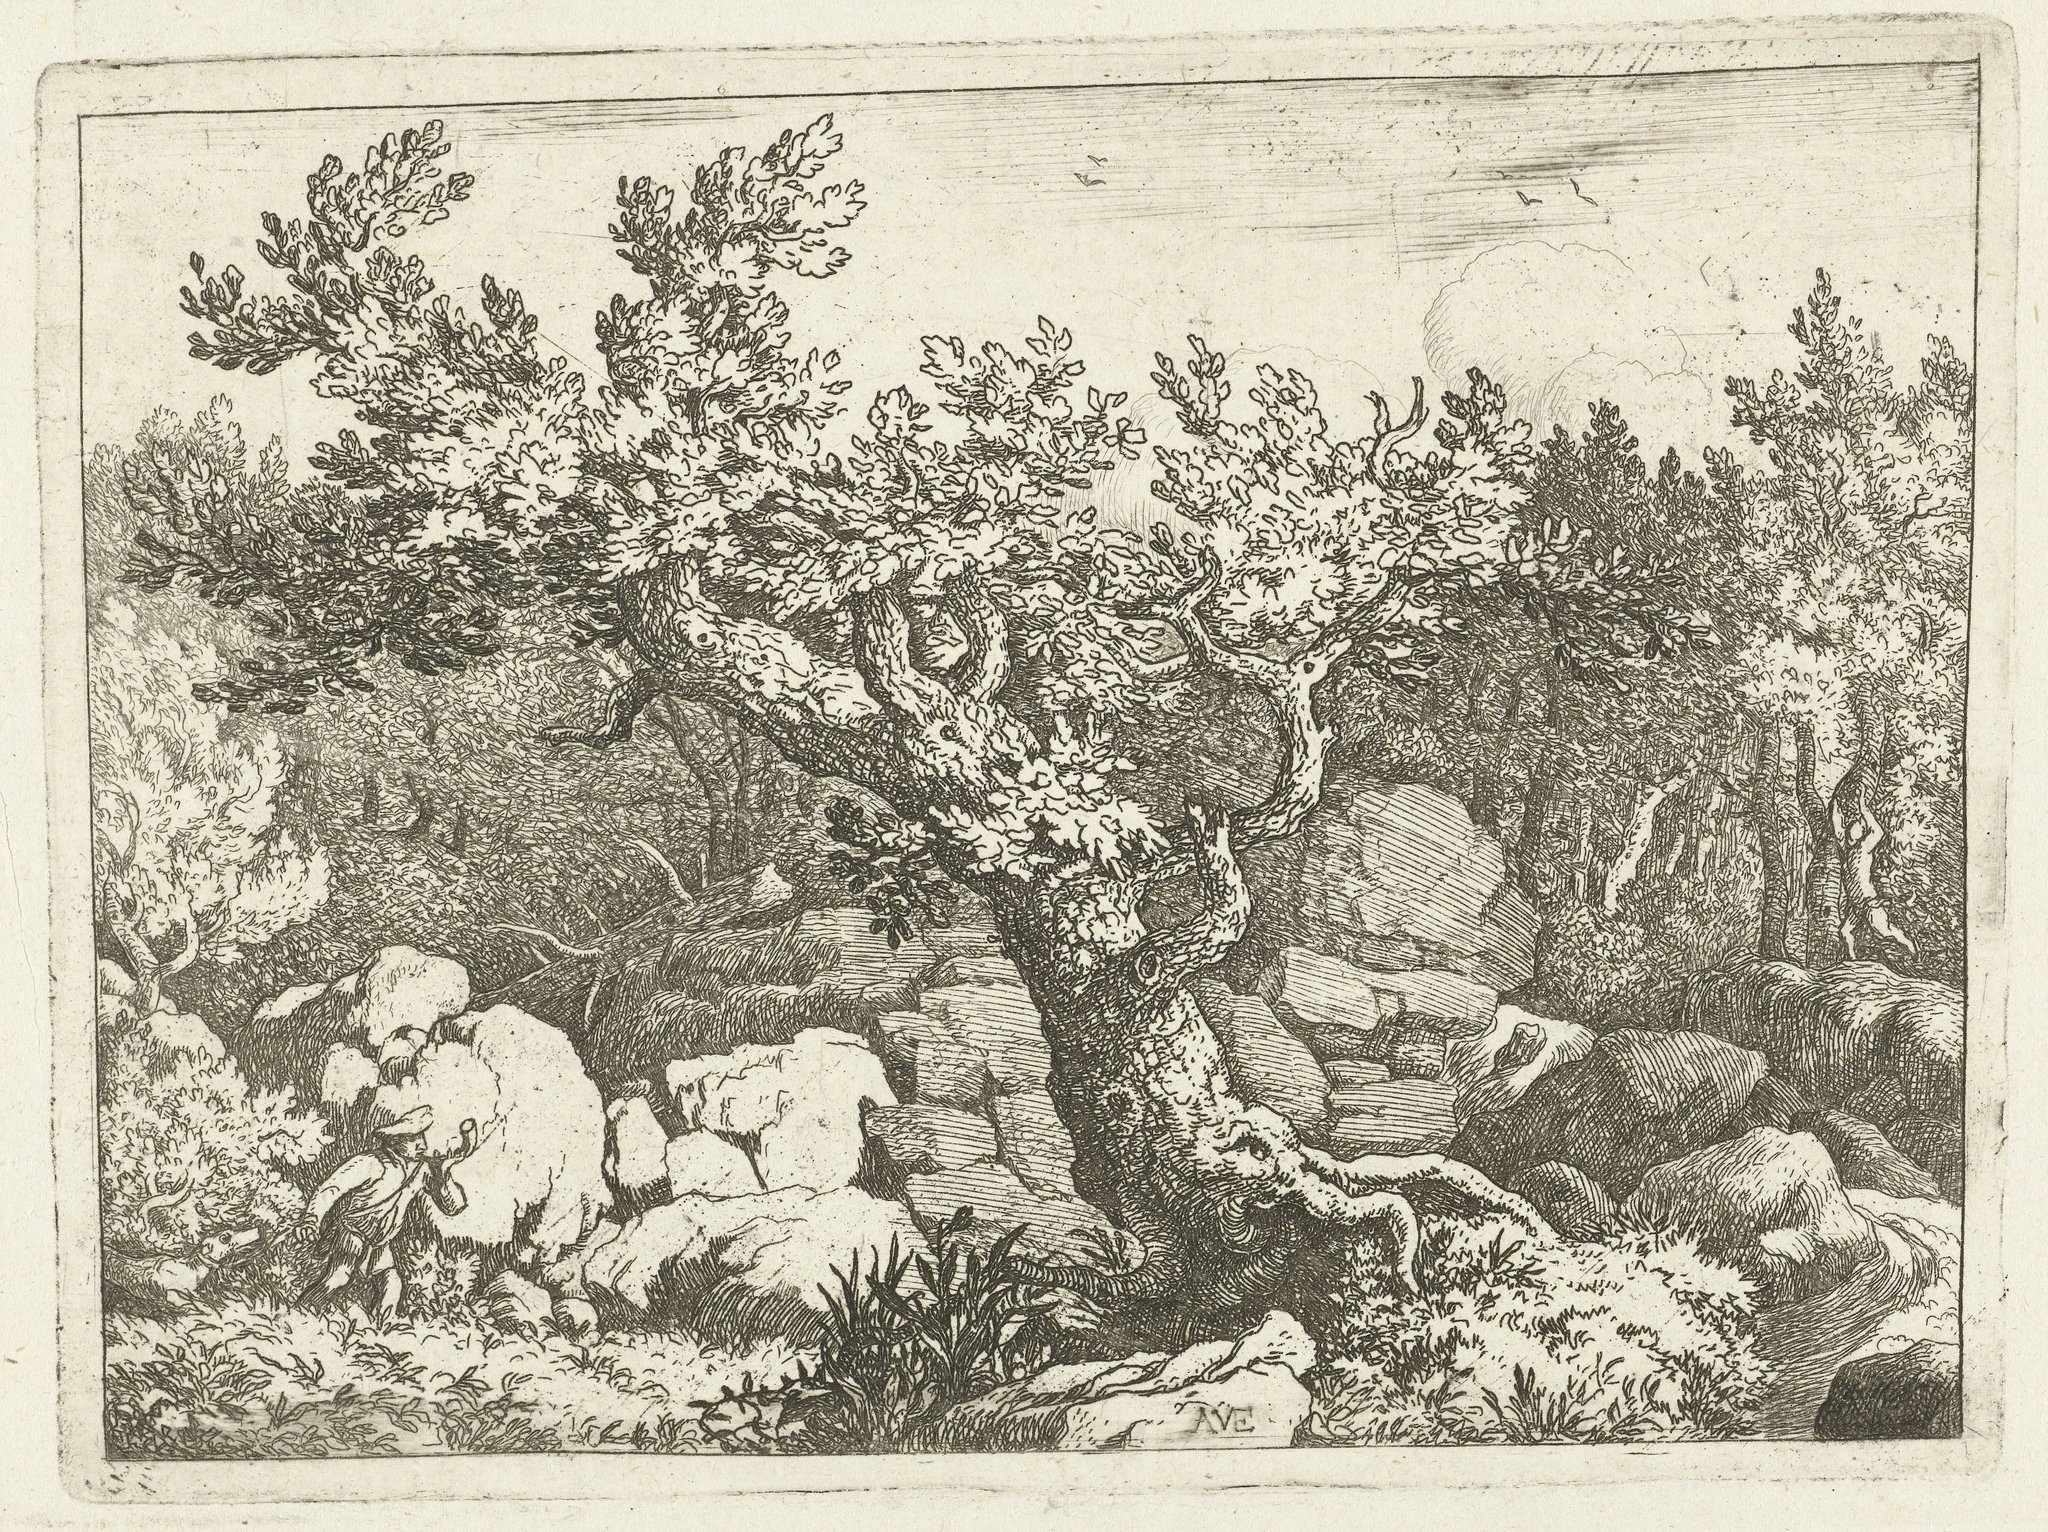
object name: print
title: Landschap met jager bij grote boom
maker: allaert van everdingen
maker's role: draughtsman, painter, print maker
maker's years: 1621-1675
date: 1631-1675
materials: paper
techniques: etching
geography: netherlands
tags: landscapes (+ landscape with figures, staffage)